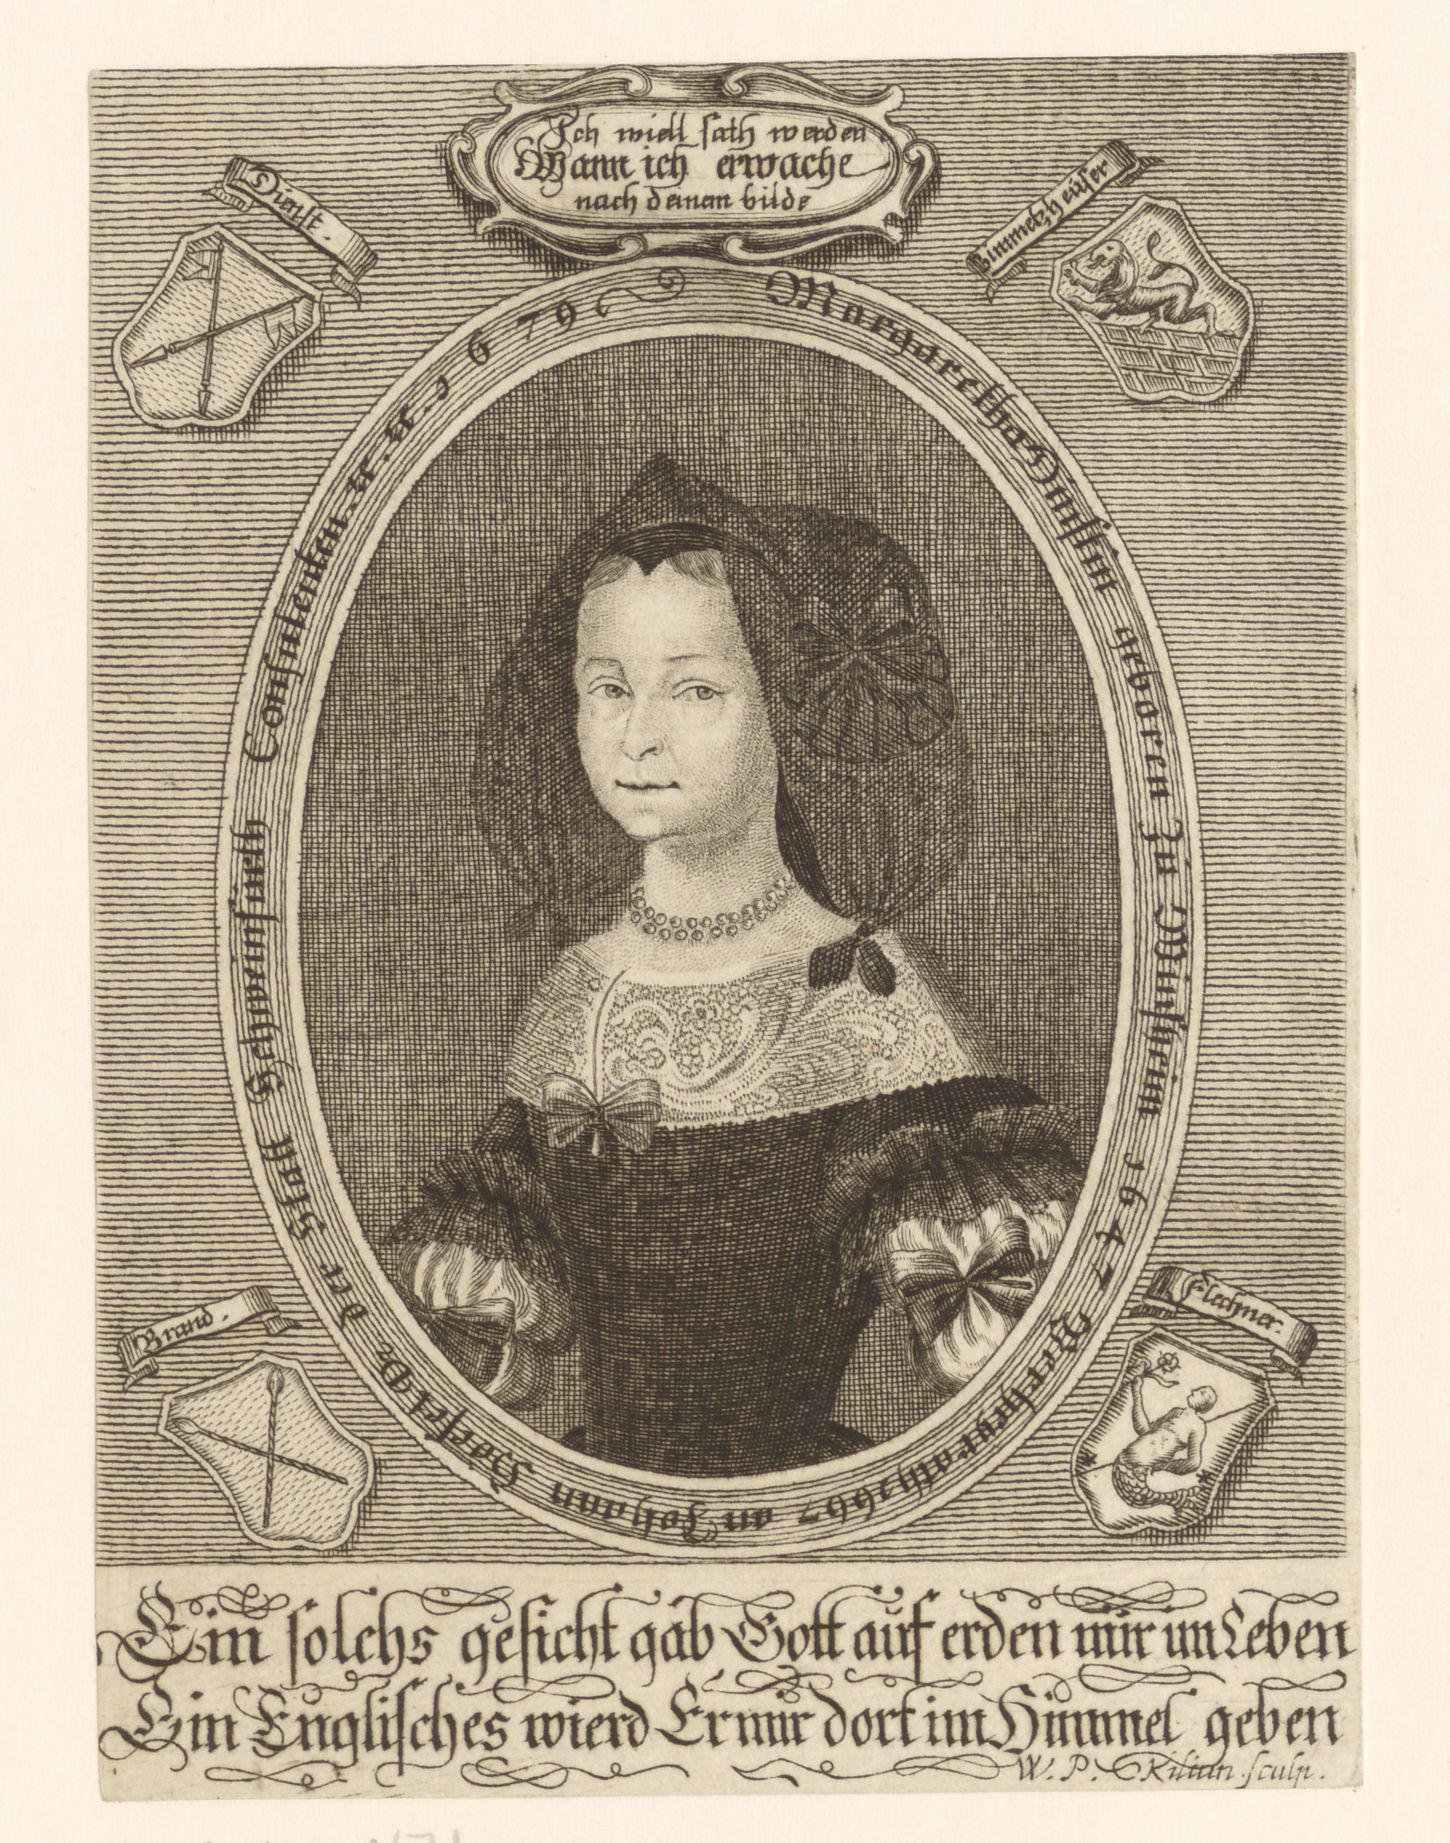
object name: print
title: Portret van Margaretha Höfel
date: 1679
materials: paper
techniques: engraving, etching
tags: historical persons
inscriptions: collector's mark: Lugt 2228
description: Tekst in het Latijn in de omlijsting en in de ondermarge.